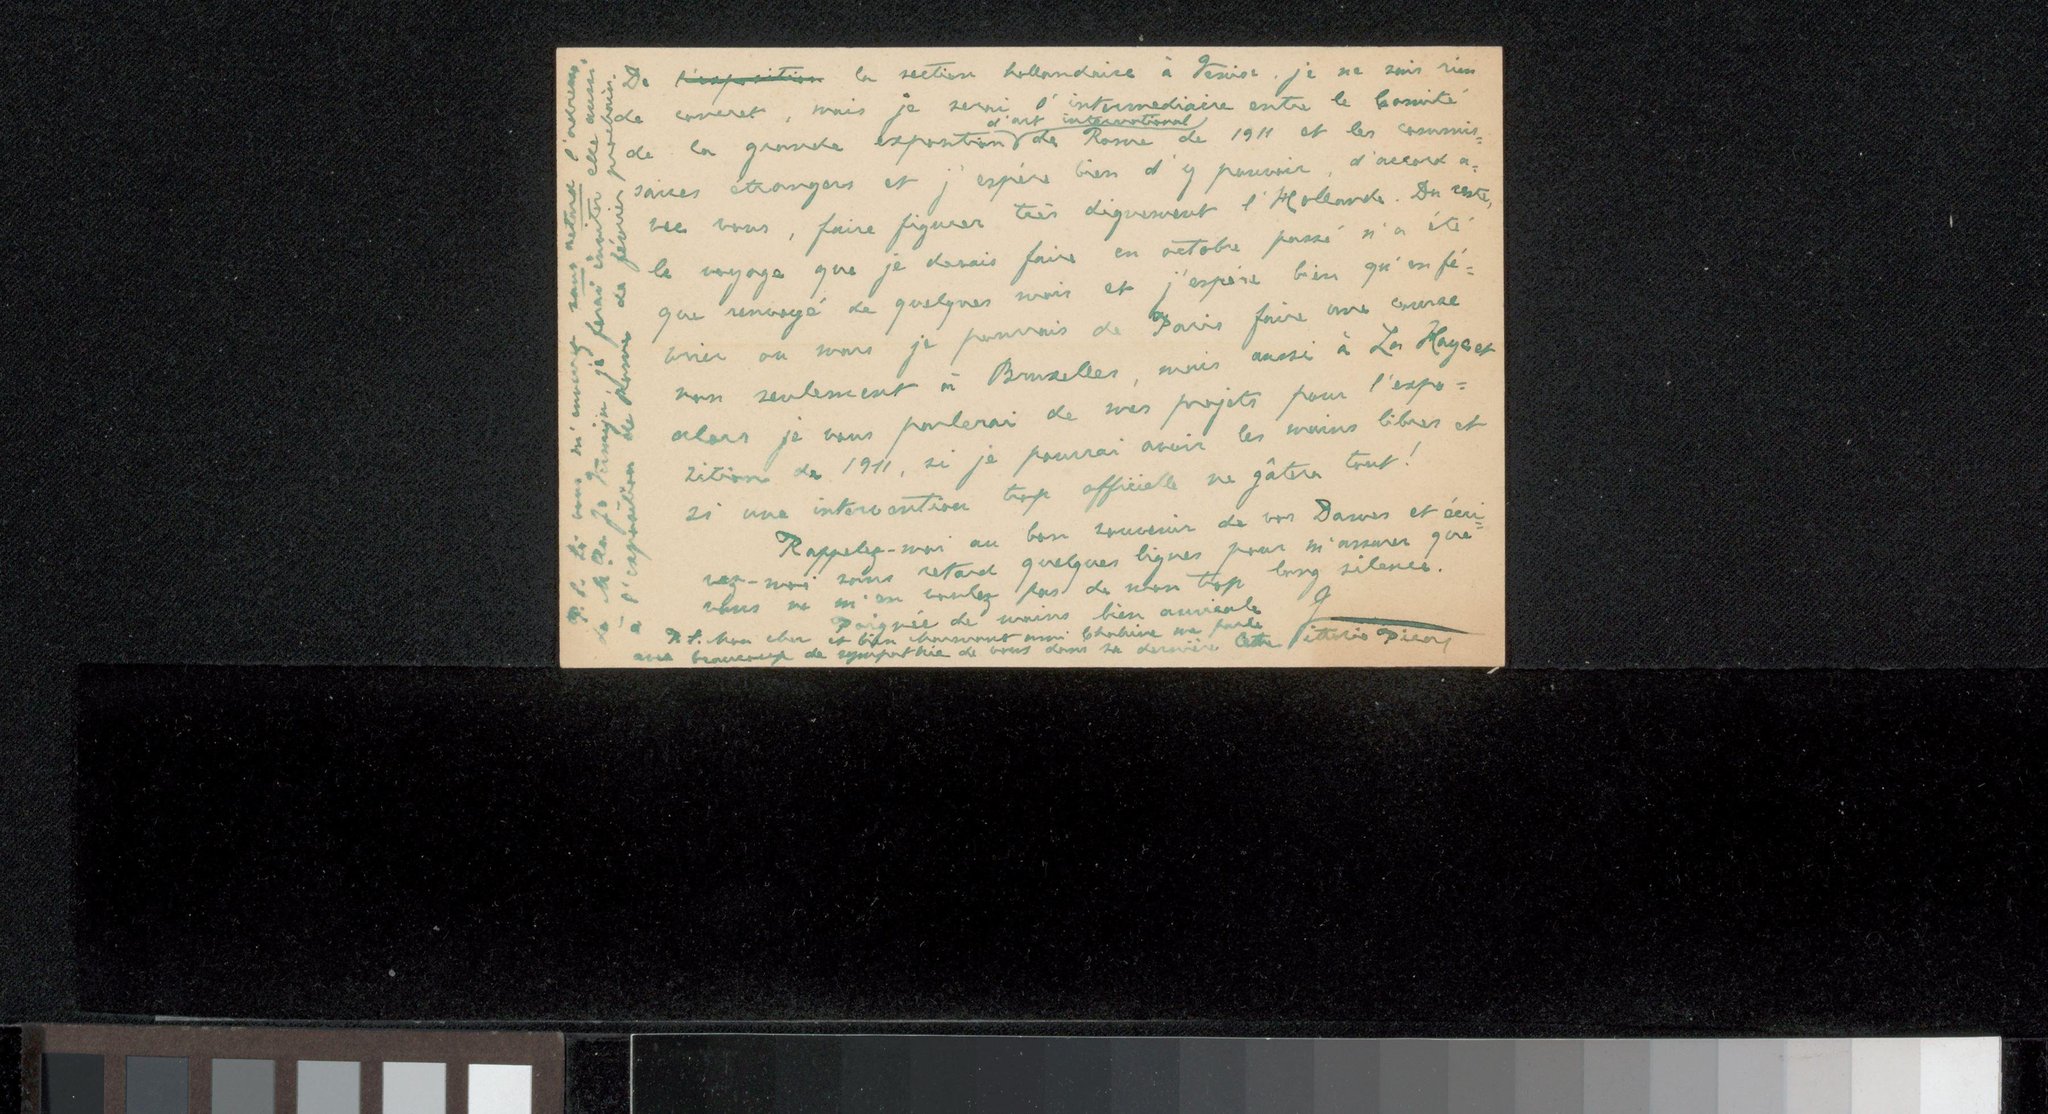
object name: letter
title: Brief aan Philip Zilcken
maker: vittorio pica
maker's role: criticus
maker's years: 1864-1930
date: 1908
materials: cardboard, ink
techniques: pen, printing, writing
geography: milan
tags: jo vermijne, painter, draughtsman, philip zilcken, the graphic arts, education, tuition of the artist (in general), painting (including book-illumination, miniature-painting), exhibition ~ art, printed matter, brussels, paris, venice, rome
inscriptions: collector's mark: ‘RPK’